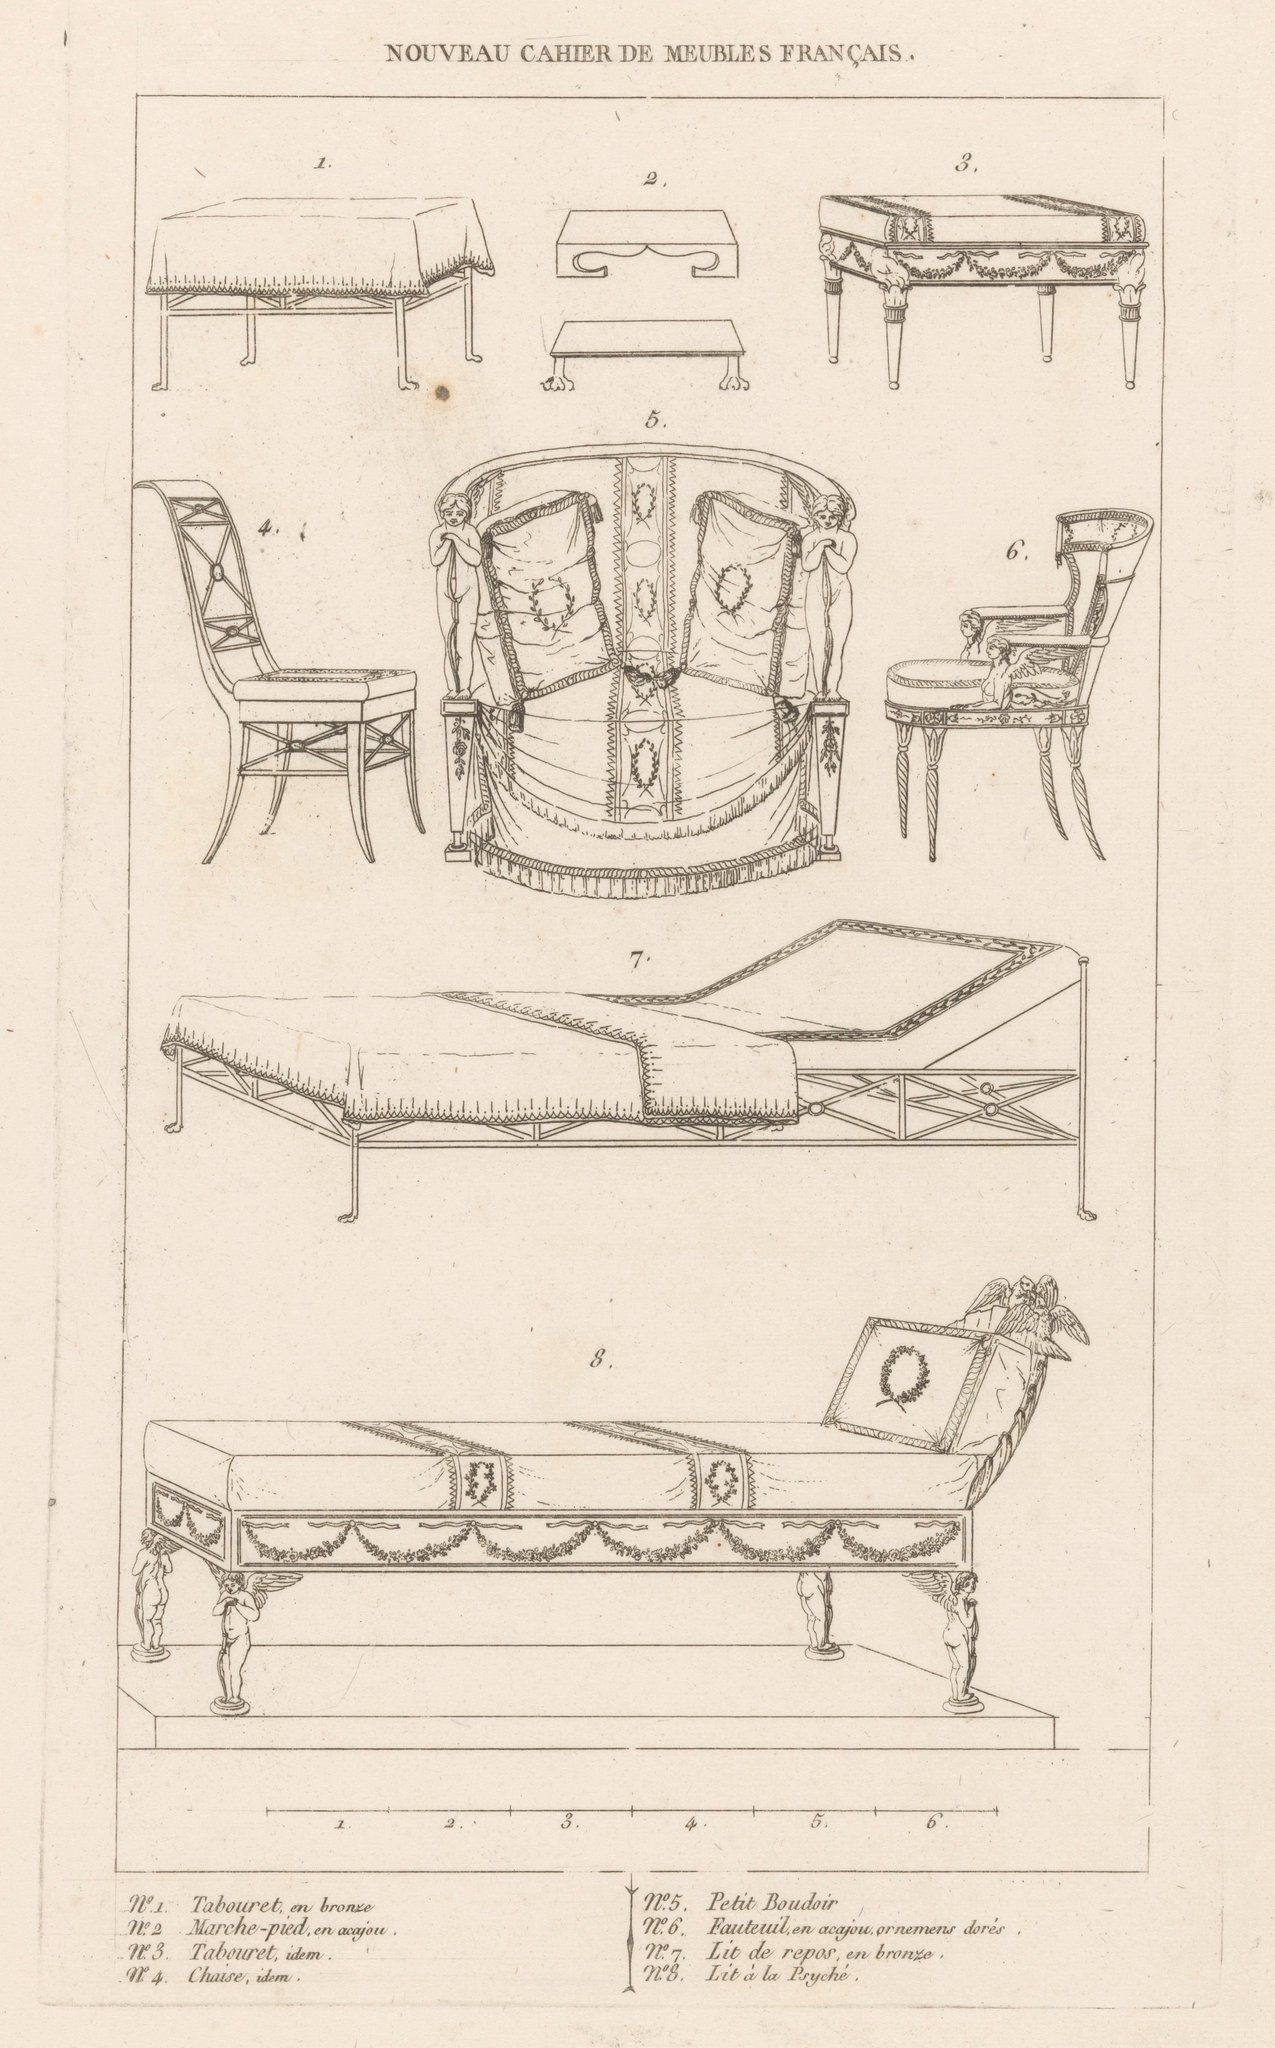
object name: print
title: Nouveau Cahier de Meubles Français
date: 1815-1825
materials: paper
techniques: etching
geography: france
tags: seating furniture, bed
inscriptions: collector's mark: Lugt 2228, collector's mark: Lugt 2760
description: Acht empire meubelen zoals voetenbanken, twee stoelen, een fauteuil en twee ligbedden. In de ondermarge een Franse beschrijving.